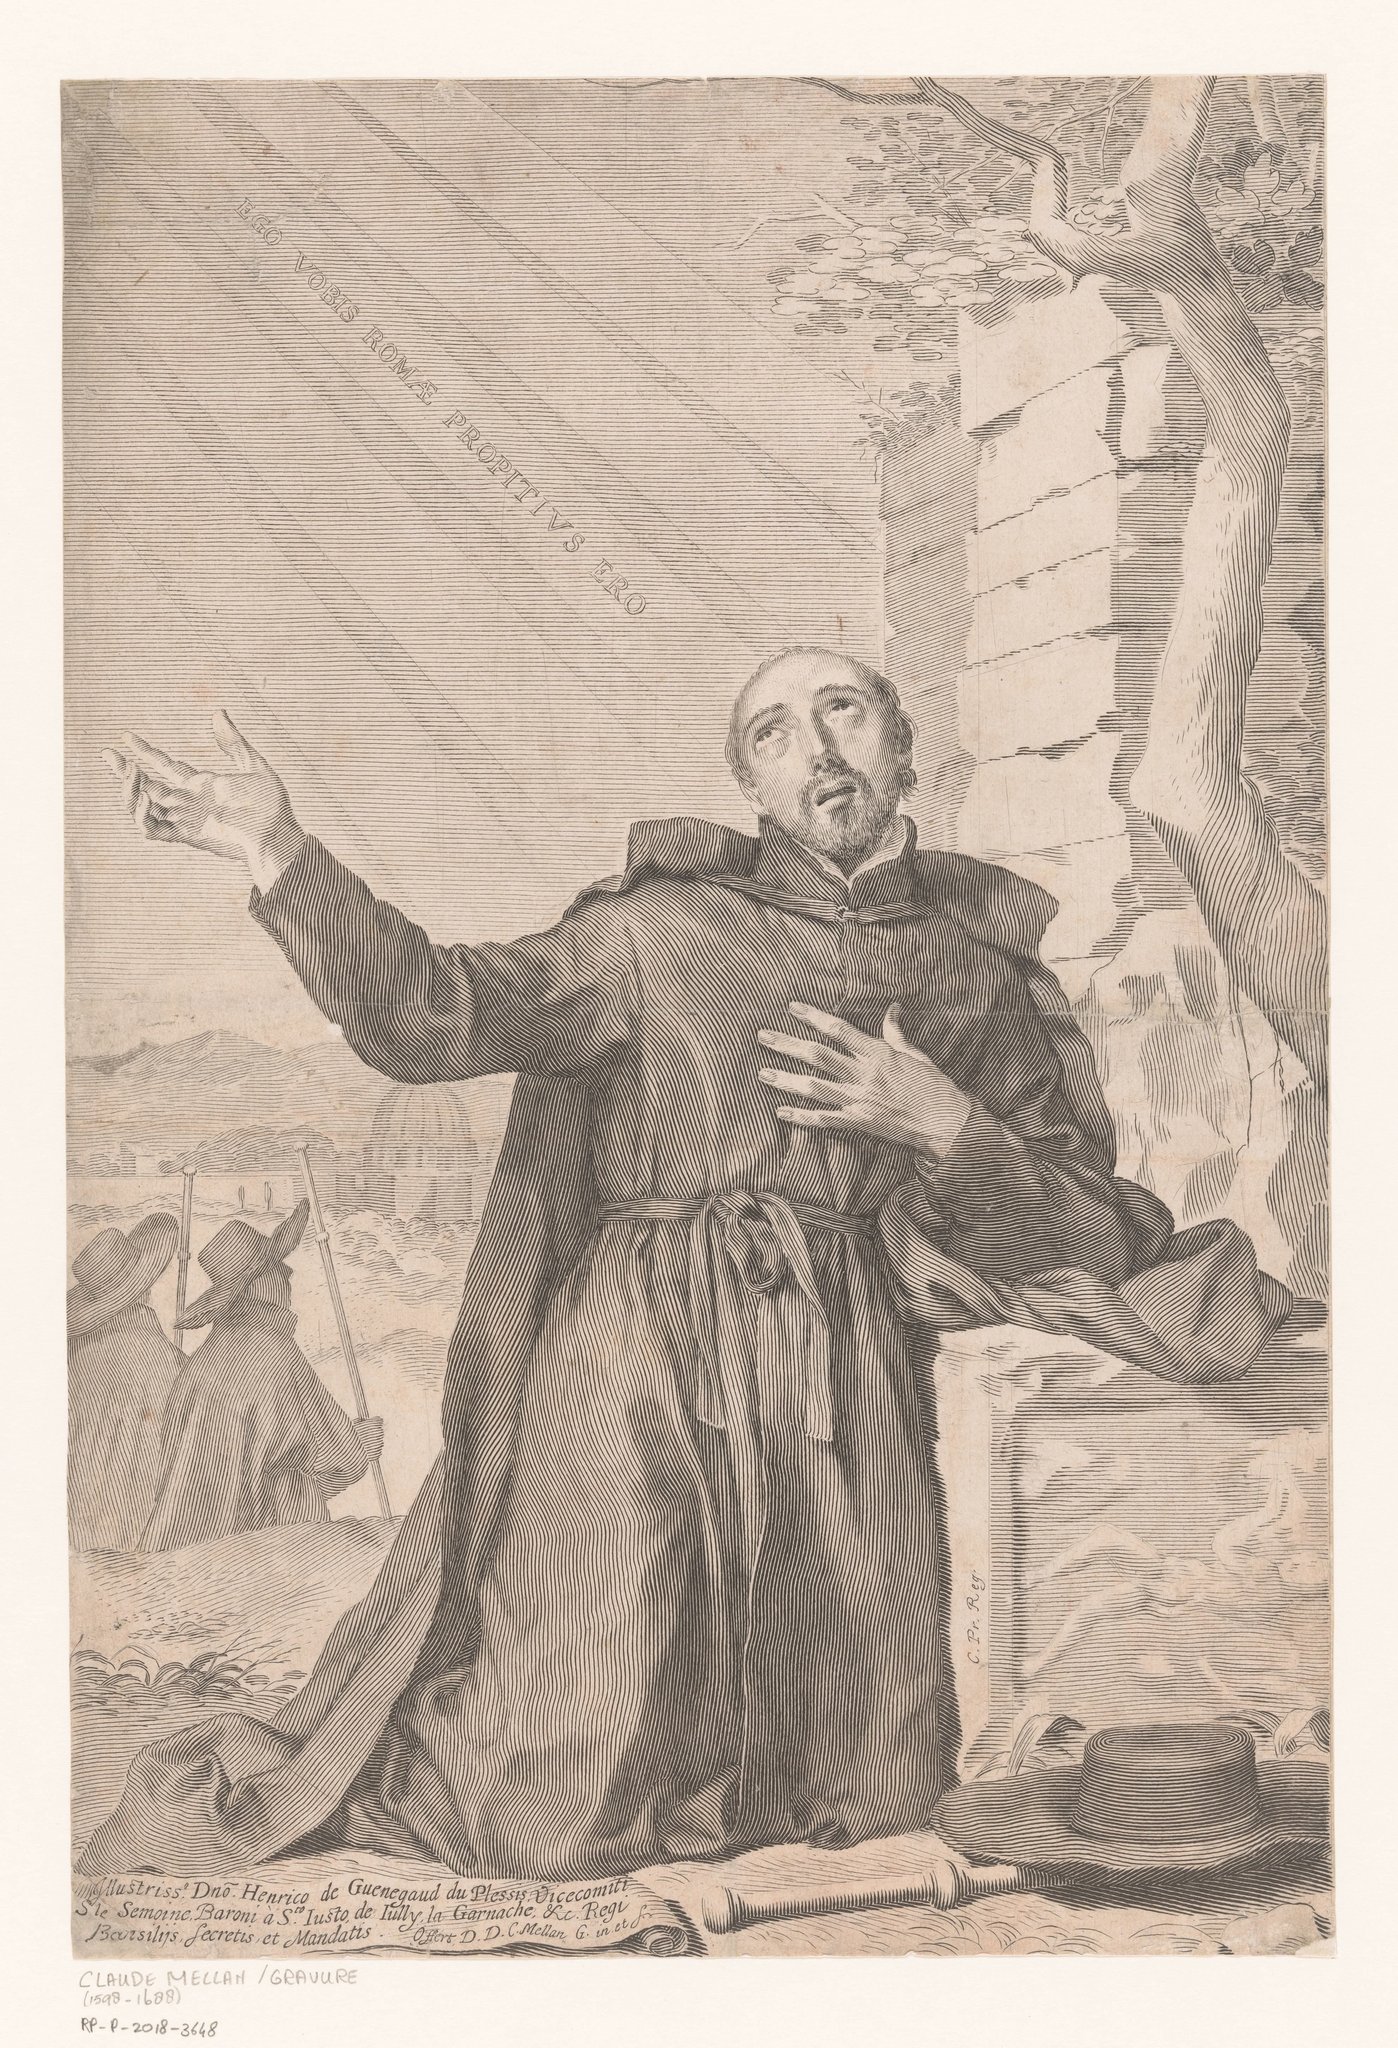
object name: print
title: H. Ignatius van Loyola in extase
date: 1608-1676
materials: paper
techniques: engraving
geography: france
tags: pilgrimage, pilgrim(s) under way, visions of st. ignatius of loyola, rome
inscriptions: collector's mark: Lugt 2228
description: De heilige Ignatius van Loyola, knielend in extase voor een blok met reliëf. Op de achtergrond links lopen pelgrims naar Rome.